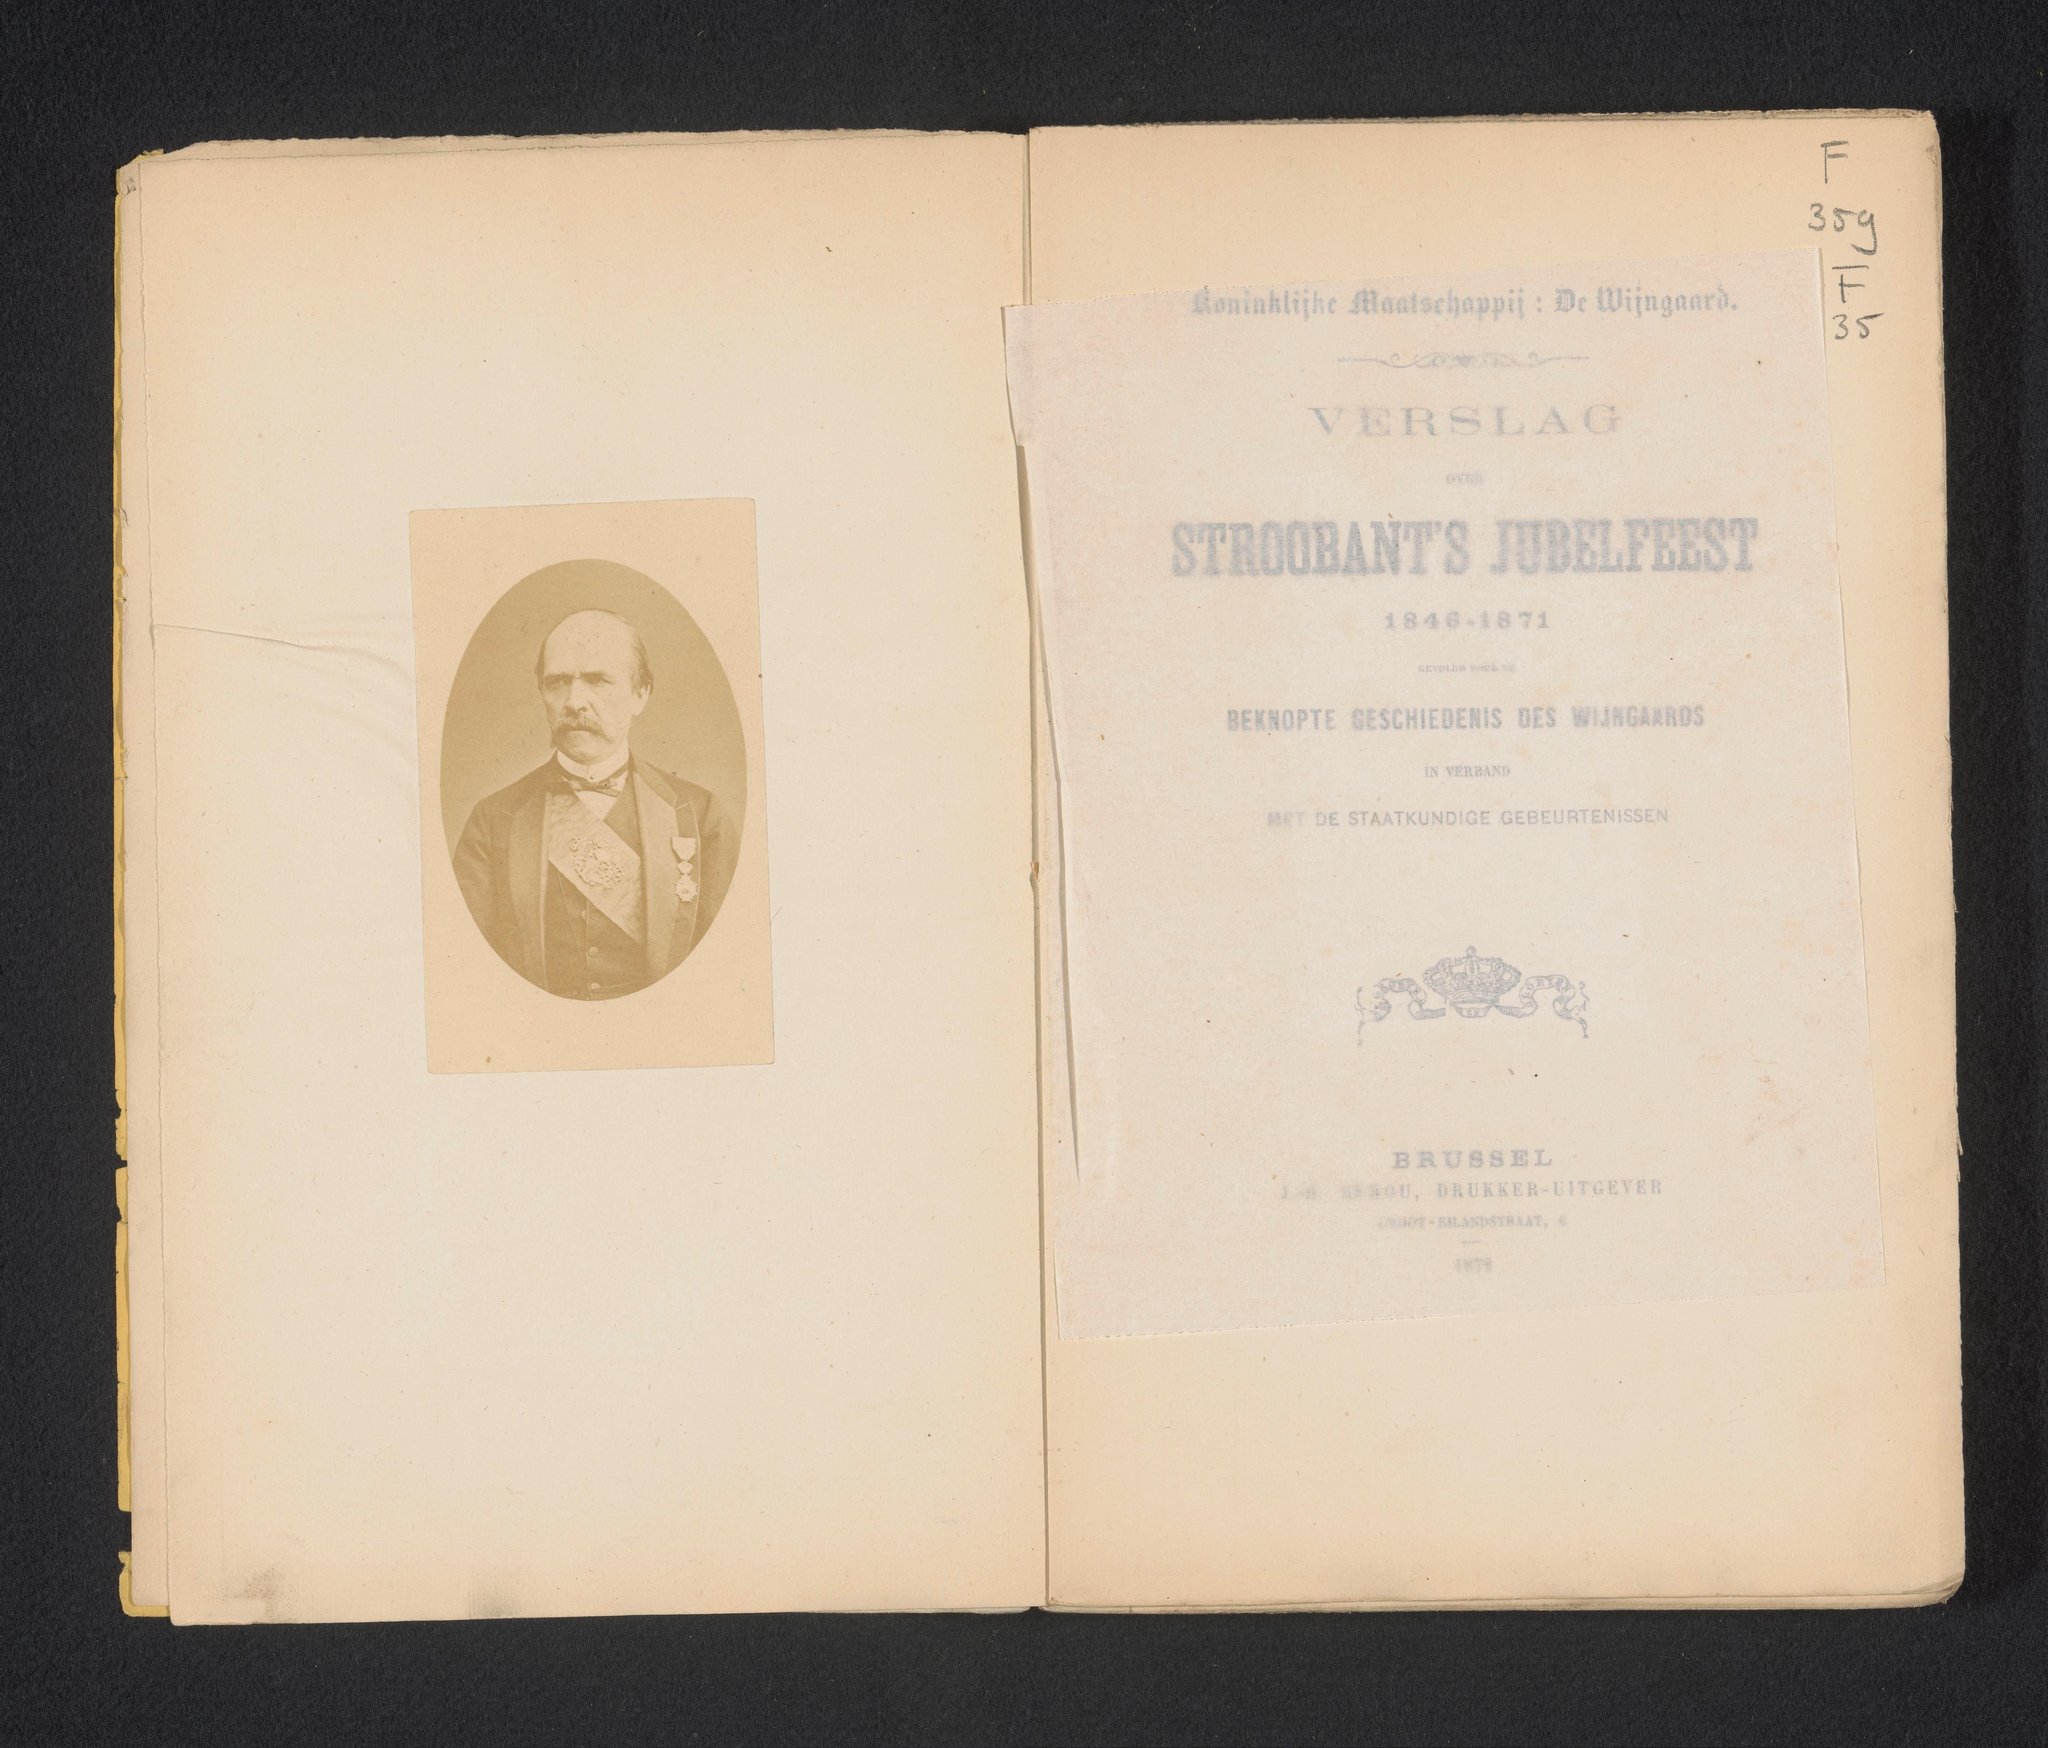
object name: page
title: Portret van Eugène Stroobant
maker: Anonymous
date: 1867-1872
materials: photographic support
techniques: albumen print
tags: politician, historical persons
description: Foto tegenover titelpagina, achter semi-transparante omslag.